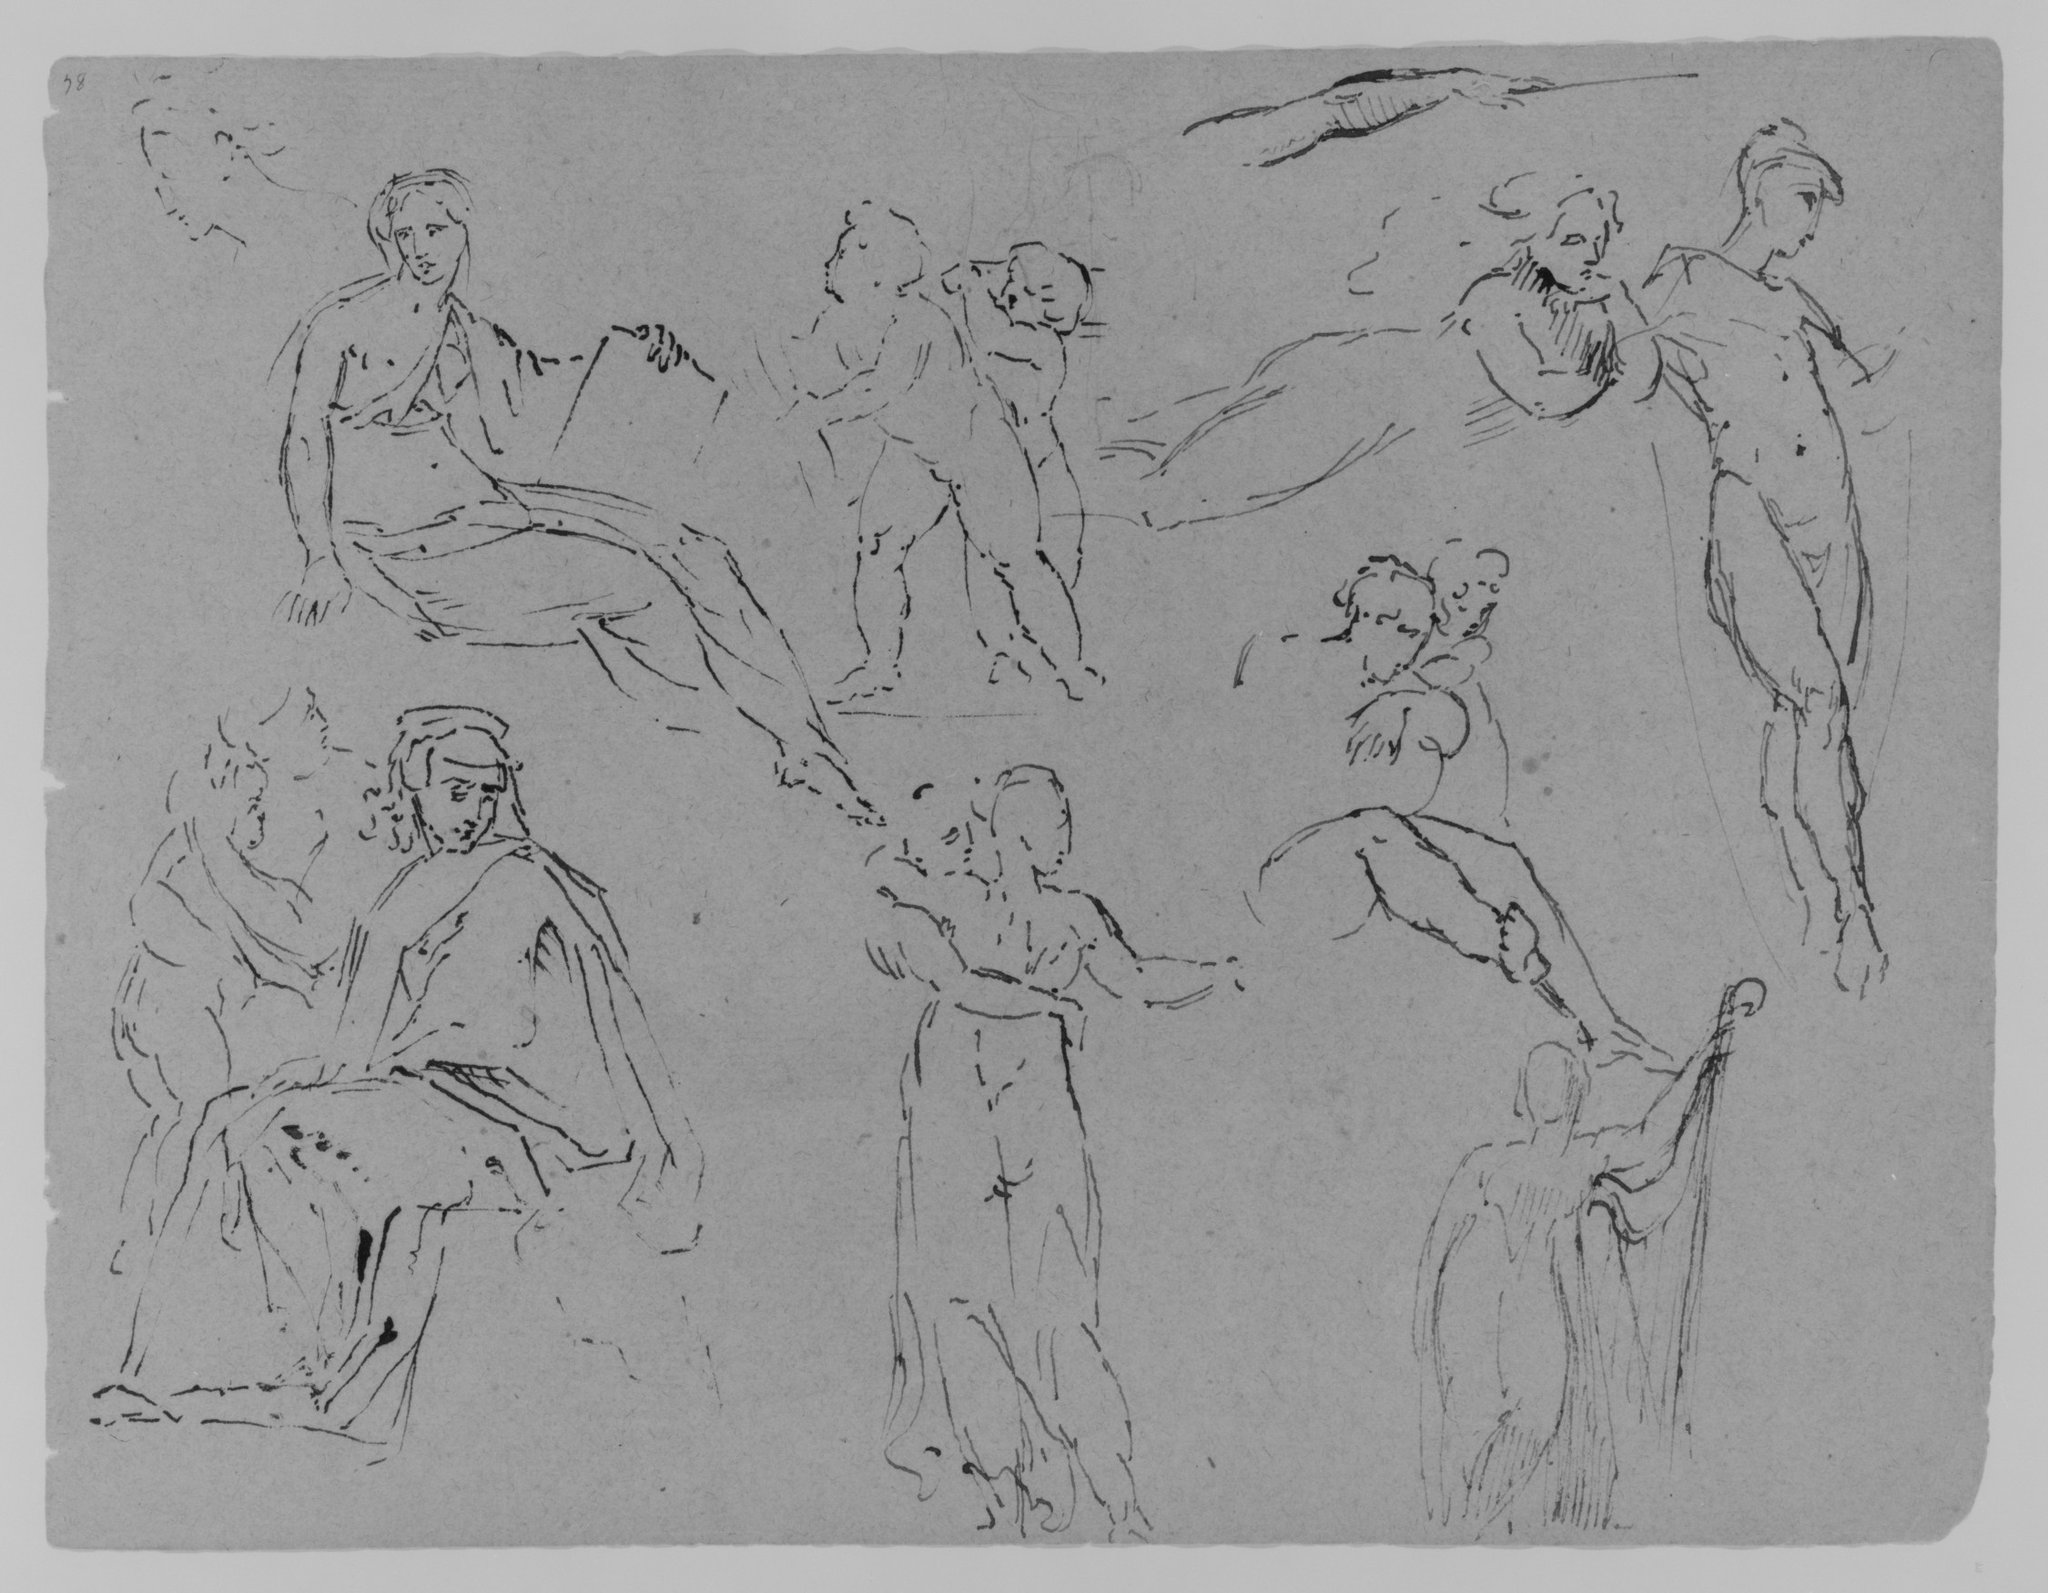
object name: drawing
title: (From Sketchbook)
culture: american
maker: thomas sully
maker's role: artist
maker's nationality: american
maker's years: 1783-1872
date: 1810-1820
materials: ink, paper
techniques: wash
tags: men,women